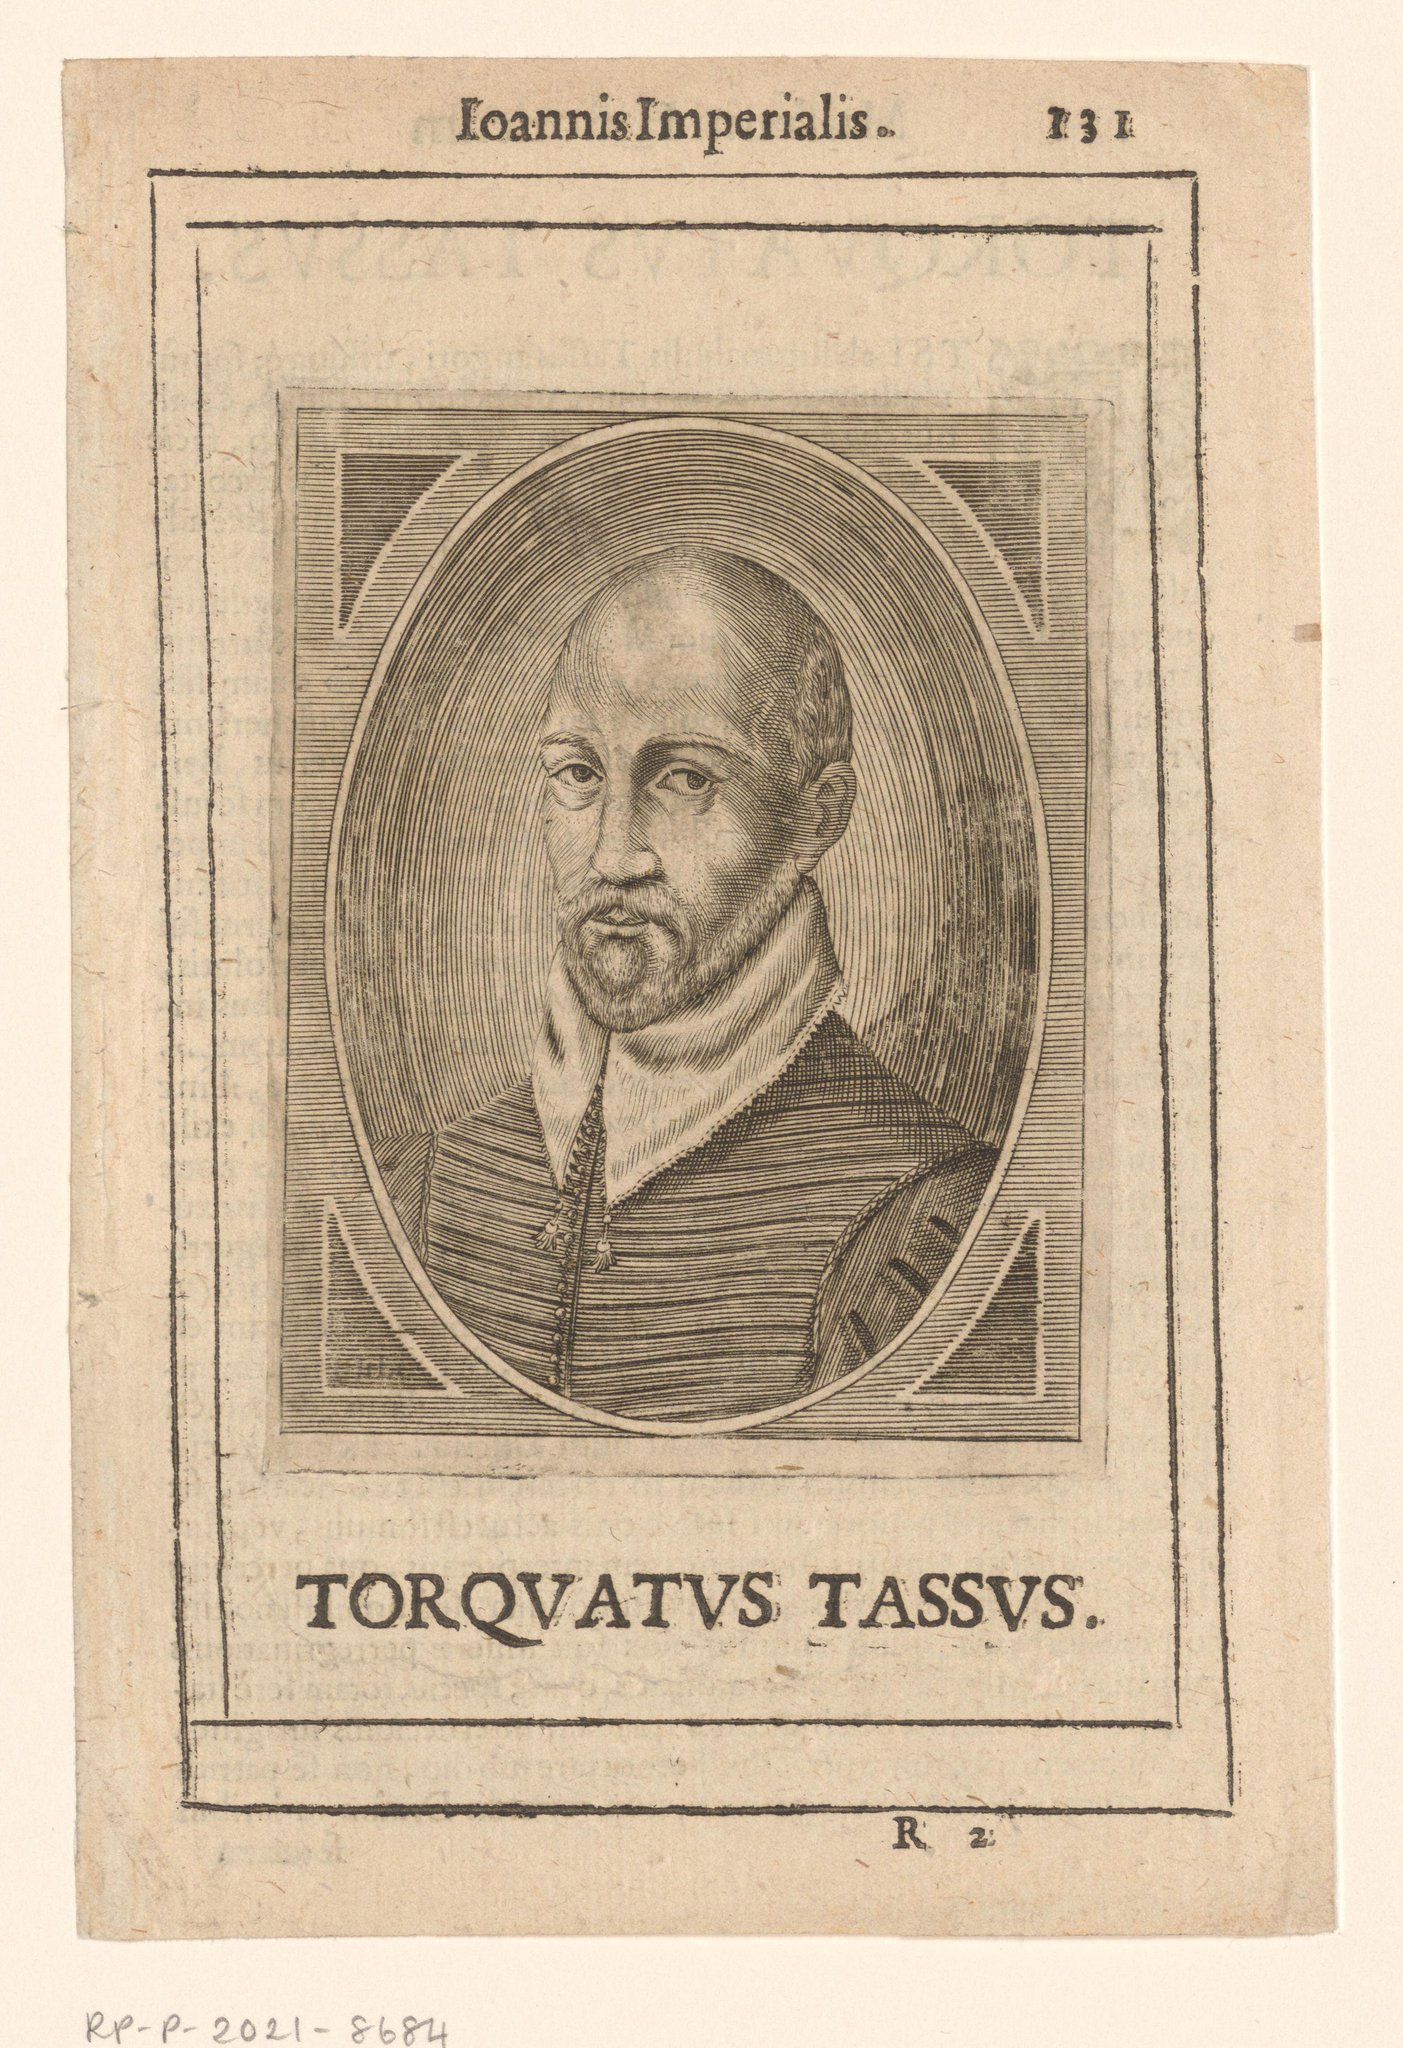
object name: print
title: Portret van Torquato Tasso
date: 1640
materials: paper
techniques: engraving, letterpress printing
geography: venice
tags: rome, torquato tasso, historical persons, writer, poet, author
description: Prent uit: Imperiallis, Joannes. Musaeum historicum et physicum. Venetië: Juntas, 1640, p. 131.